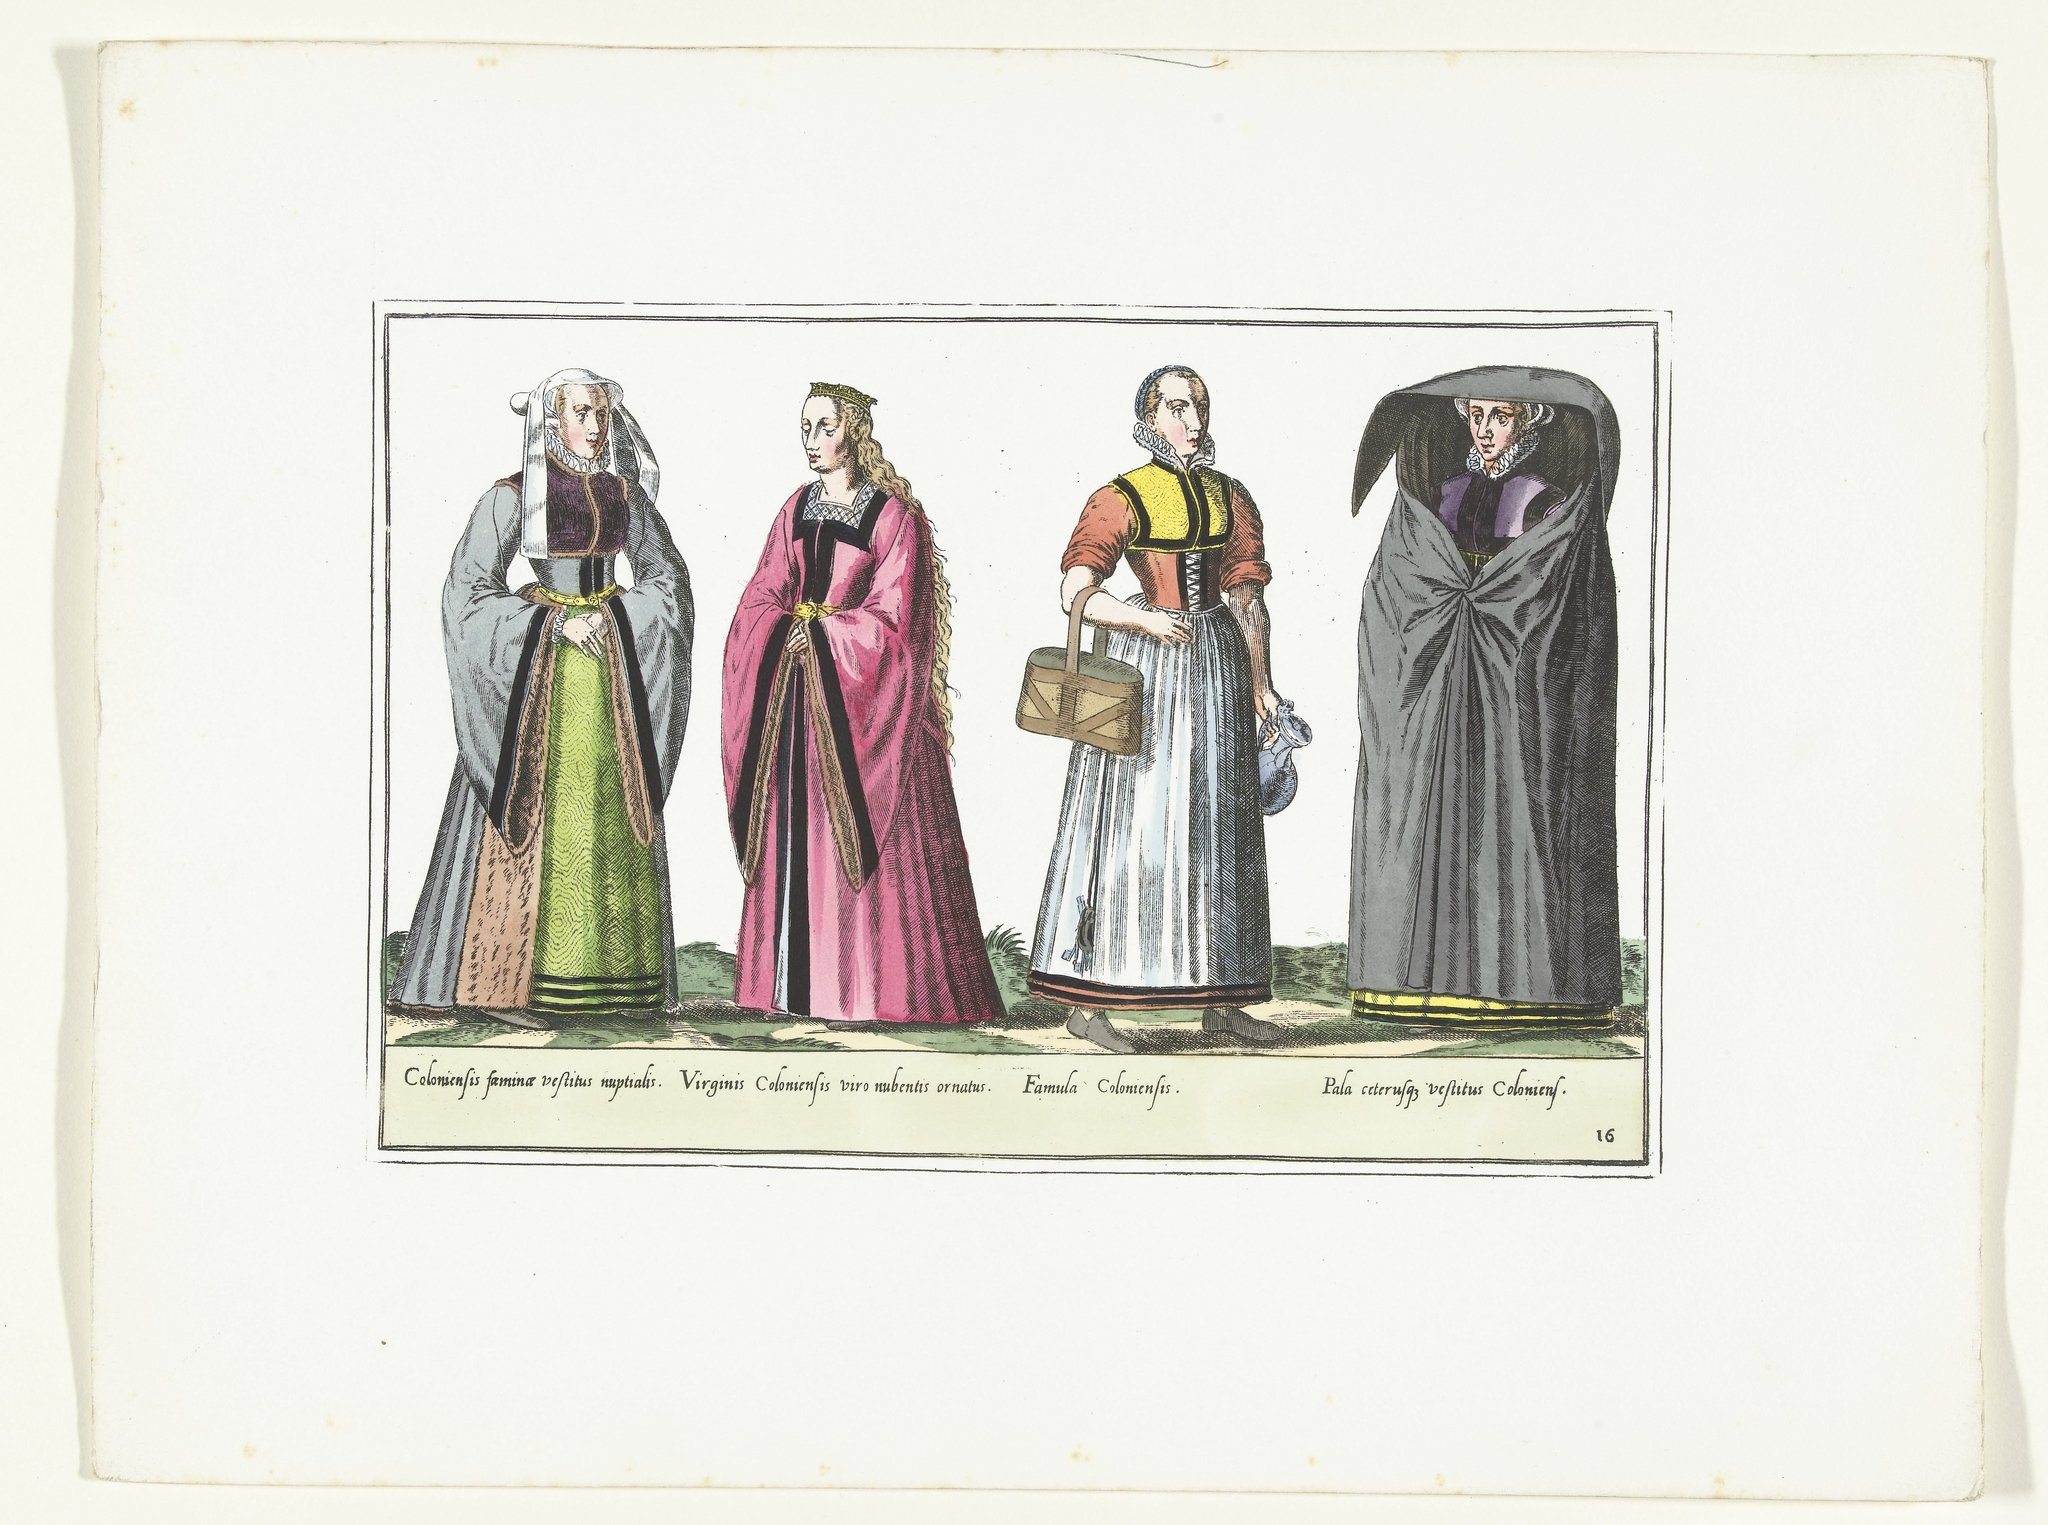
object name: costume print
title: Costumes Allemands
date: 1872-1875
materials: paper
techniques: hand coloring, printing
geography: brussels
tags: europeans: germans (+ women), coat (+ women's clothes), cape (huik) (+ women's clothes), head-gear: cap (+ women's clothes), clothes, costume (+ women's clothes), germany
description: Onderdeel van Costumes civils et militaires du XVIe siècle par A. de Bruyn, een selectie van prenten uit de Trachtenbuch van Abraham de Bruyn uit 1581 (Hollstein 248-306), in facsimile. Losbladig uitgegeven met titelbladen, verklaring en lijst van de platen door G.A. van Trigt te Brussel in 1875 met teksten van Auguste Schoy. In de Rijksmuseum Research Library met signatuur 34 C 43.